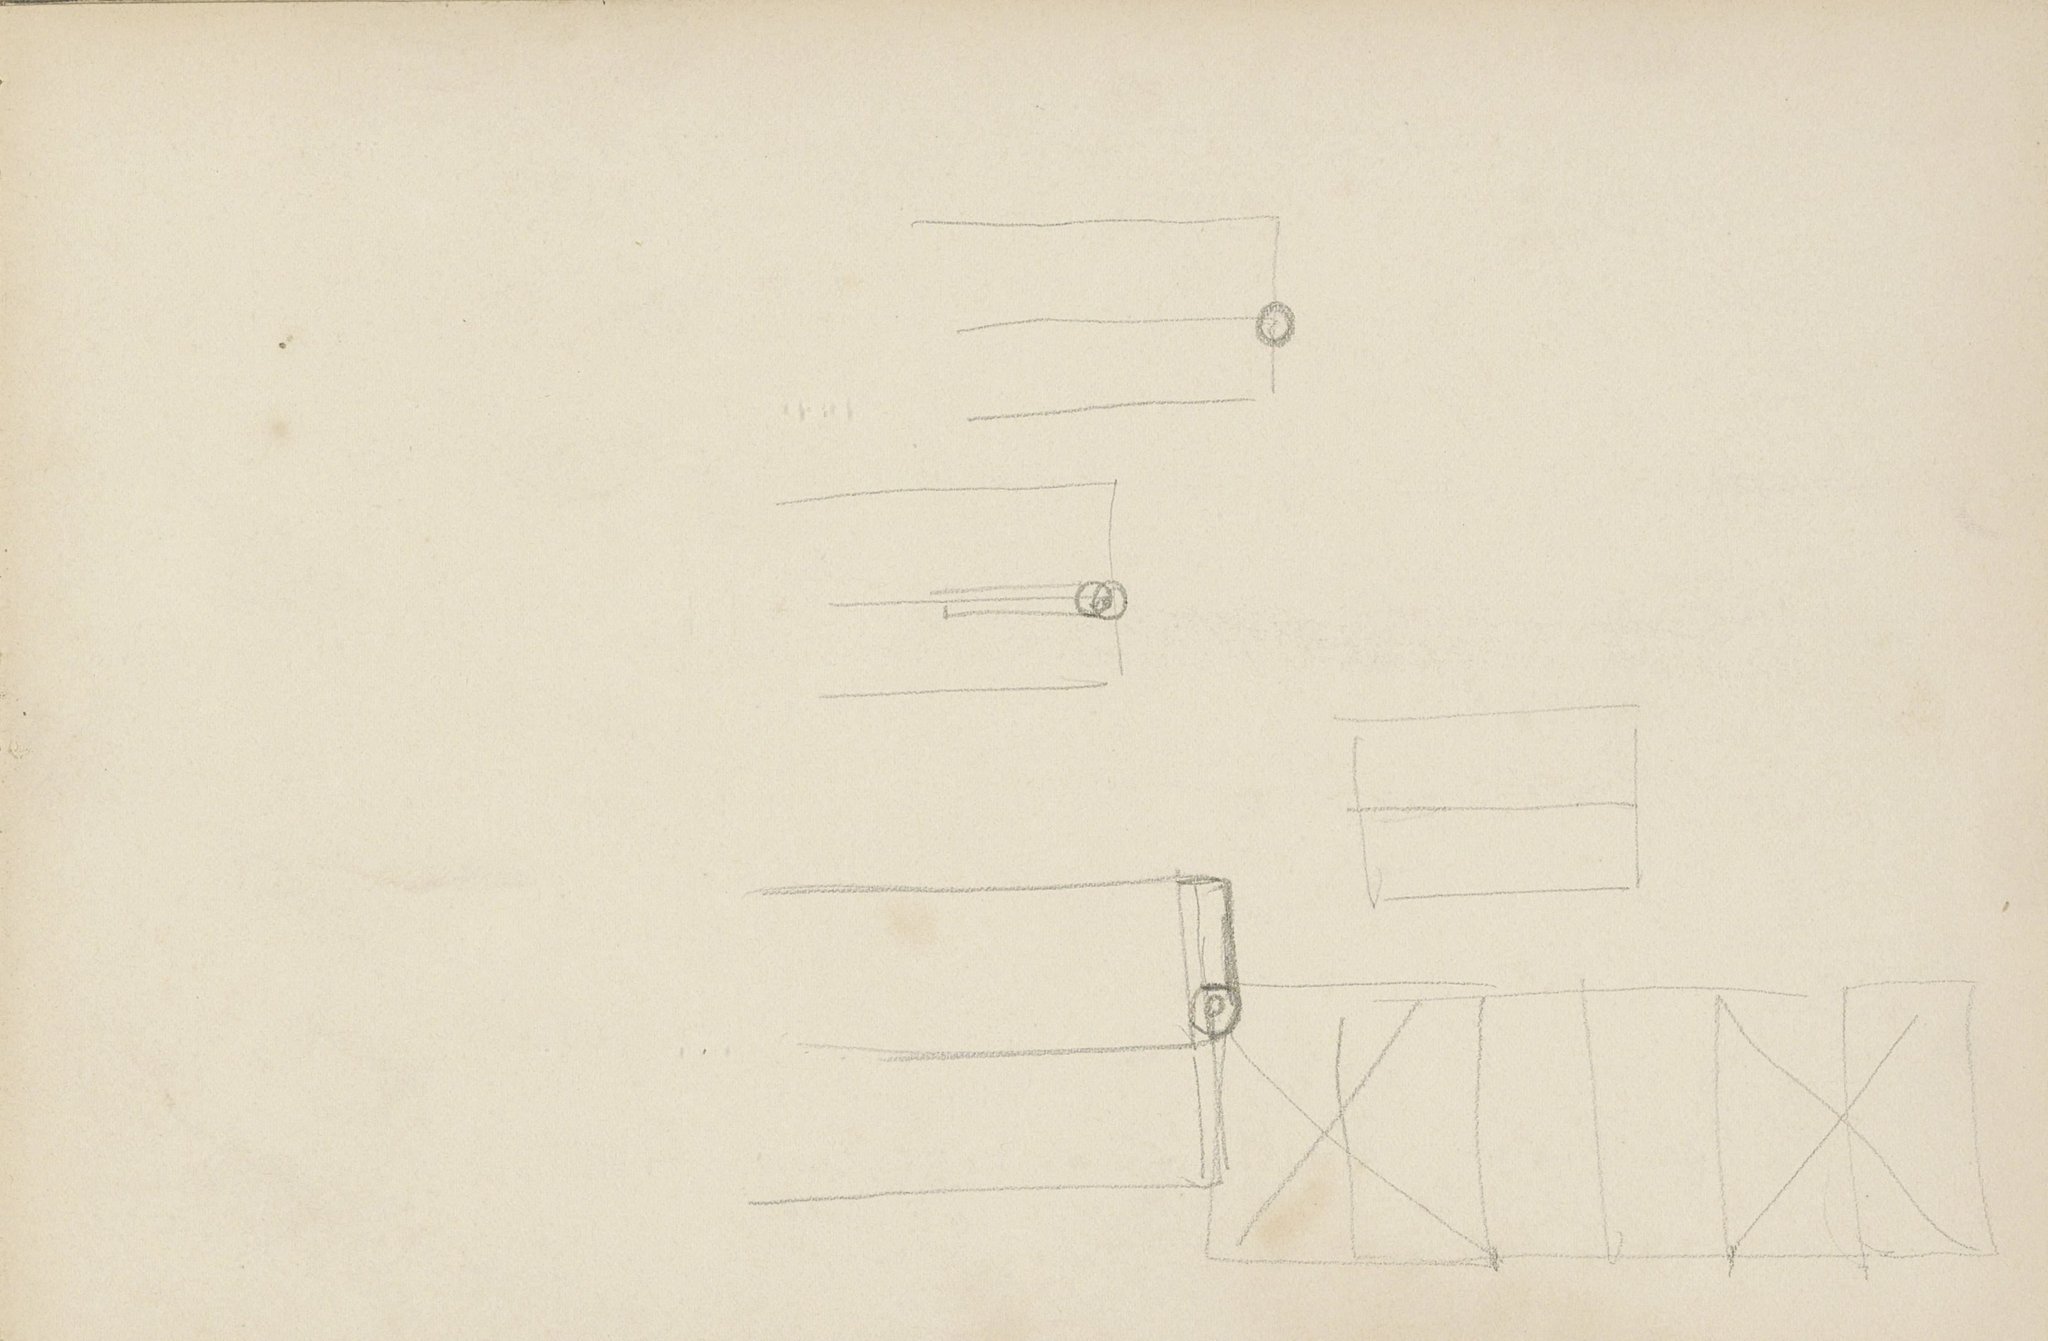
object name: sketchbook leaf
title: Geometrische vormen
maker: carel adolph lion cachet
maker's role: draughtsman, print maker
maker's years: 1864-1945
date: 1908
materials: paper, pencil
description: Blad 25 recto uit een schetsboek met 25 bladen.